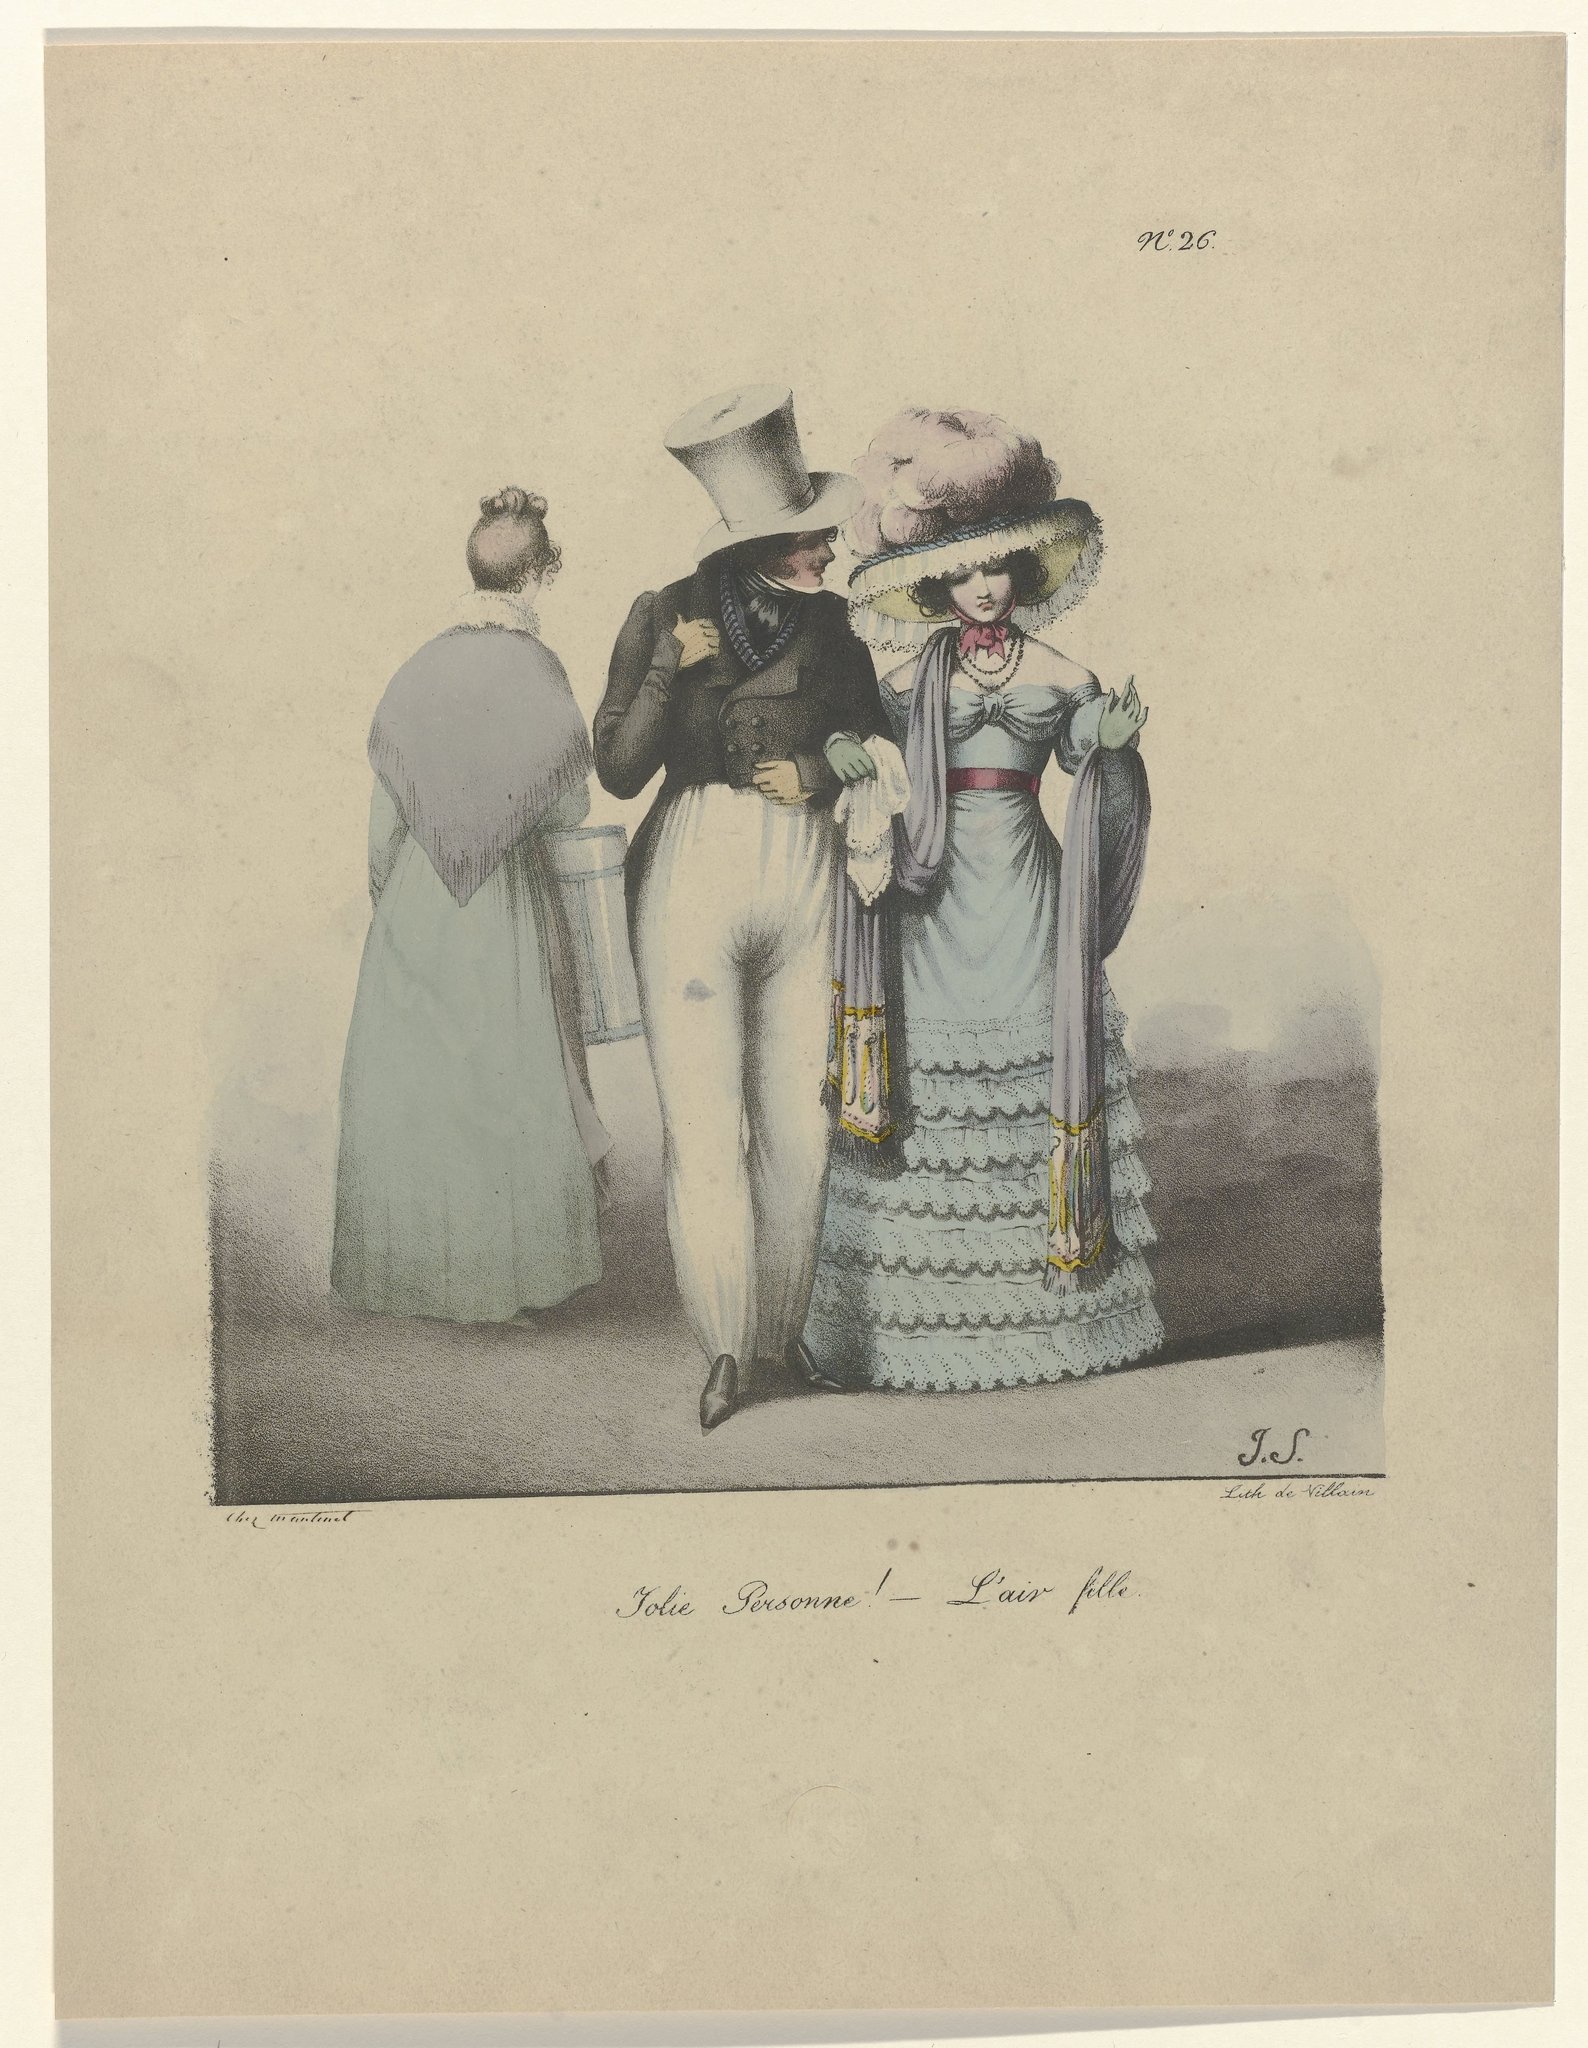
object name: fashion print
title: Jolie Personne ! L'air fille, No. 26 (1824)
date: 1824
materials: paper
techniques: hand coloring, lithograph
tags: clothing for the upper part of the body (shawl) (+ women's clothes), trousers, breeches, etc. (pantalon) (+ men's clothes), coat (frac) (+ men's clothes), fashion plates, head-gear: hat (+ women's clothes), dress, gown (+ women's clothes), working class, labourers - aa - women, arm in arm (lovers)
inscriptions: caption: ‘Jolie Personne! - L'air fille.’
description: Jong paar wandelend arm in arm. De man draagt een frak, double-breasted model met revers. Spanbroek. Hoge hoed. De vrouw in een japon met ceintuur. Accessoires: hoed met veren en striklinten, collier bestaande uit twee snoeren, sjaal met aan de uiteinden franjes, zakdoek. Achter hen, op de rug gezien, een modiste met hoedendoos in de hand. Ill. uit het 5de deel van "Recueil des Scènes familières et de Société de Paris" door Jean-Gabriel Scheffer en Edmé Jean Pigal, Paris, Chez Martinet, 1824.